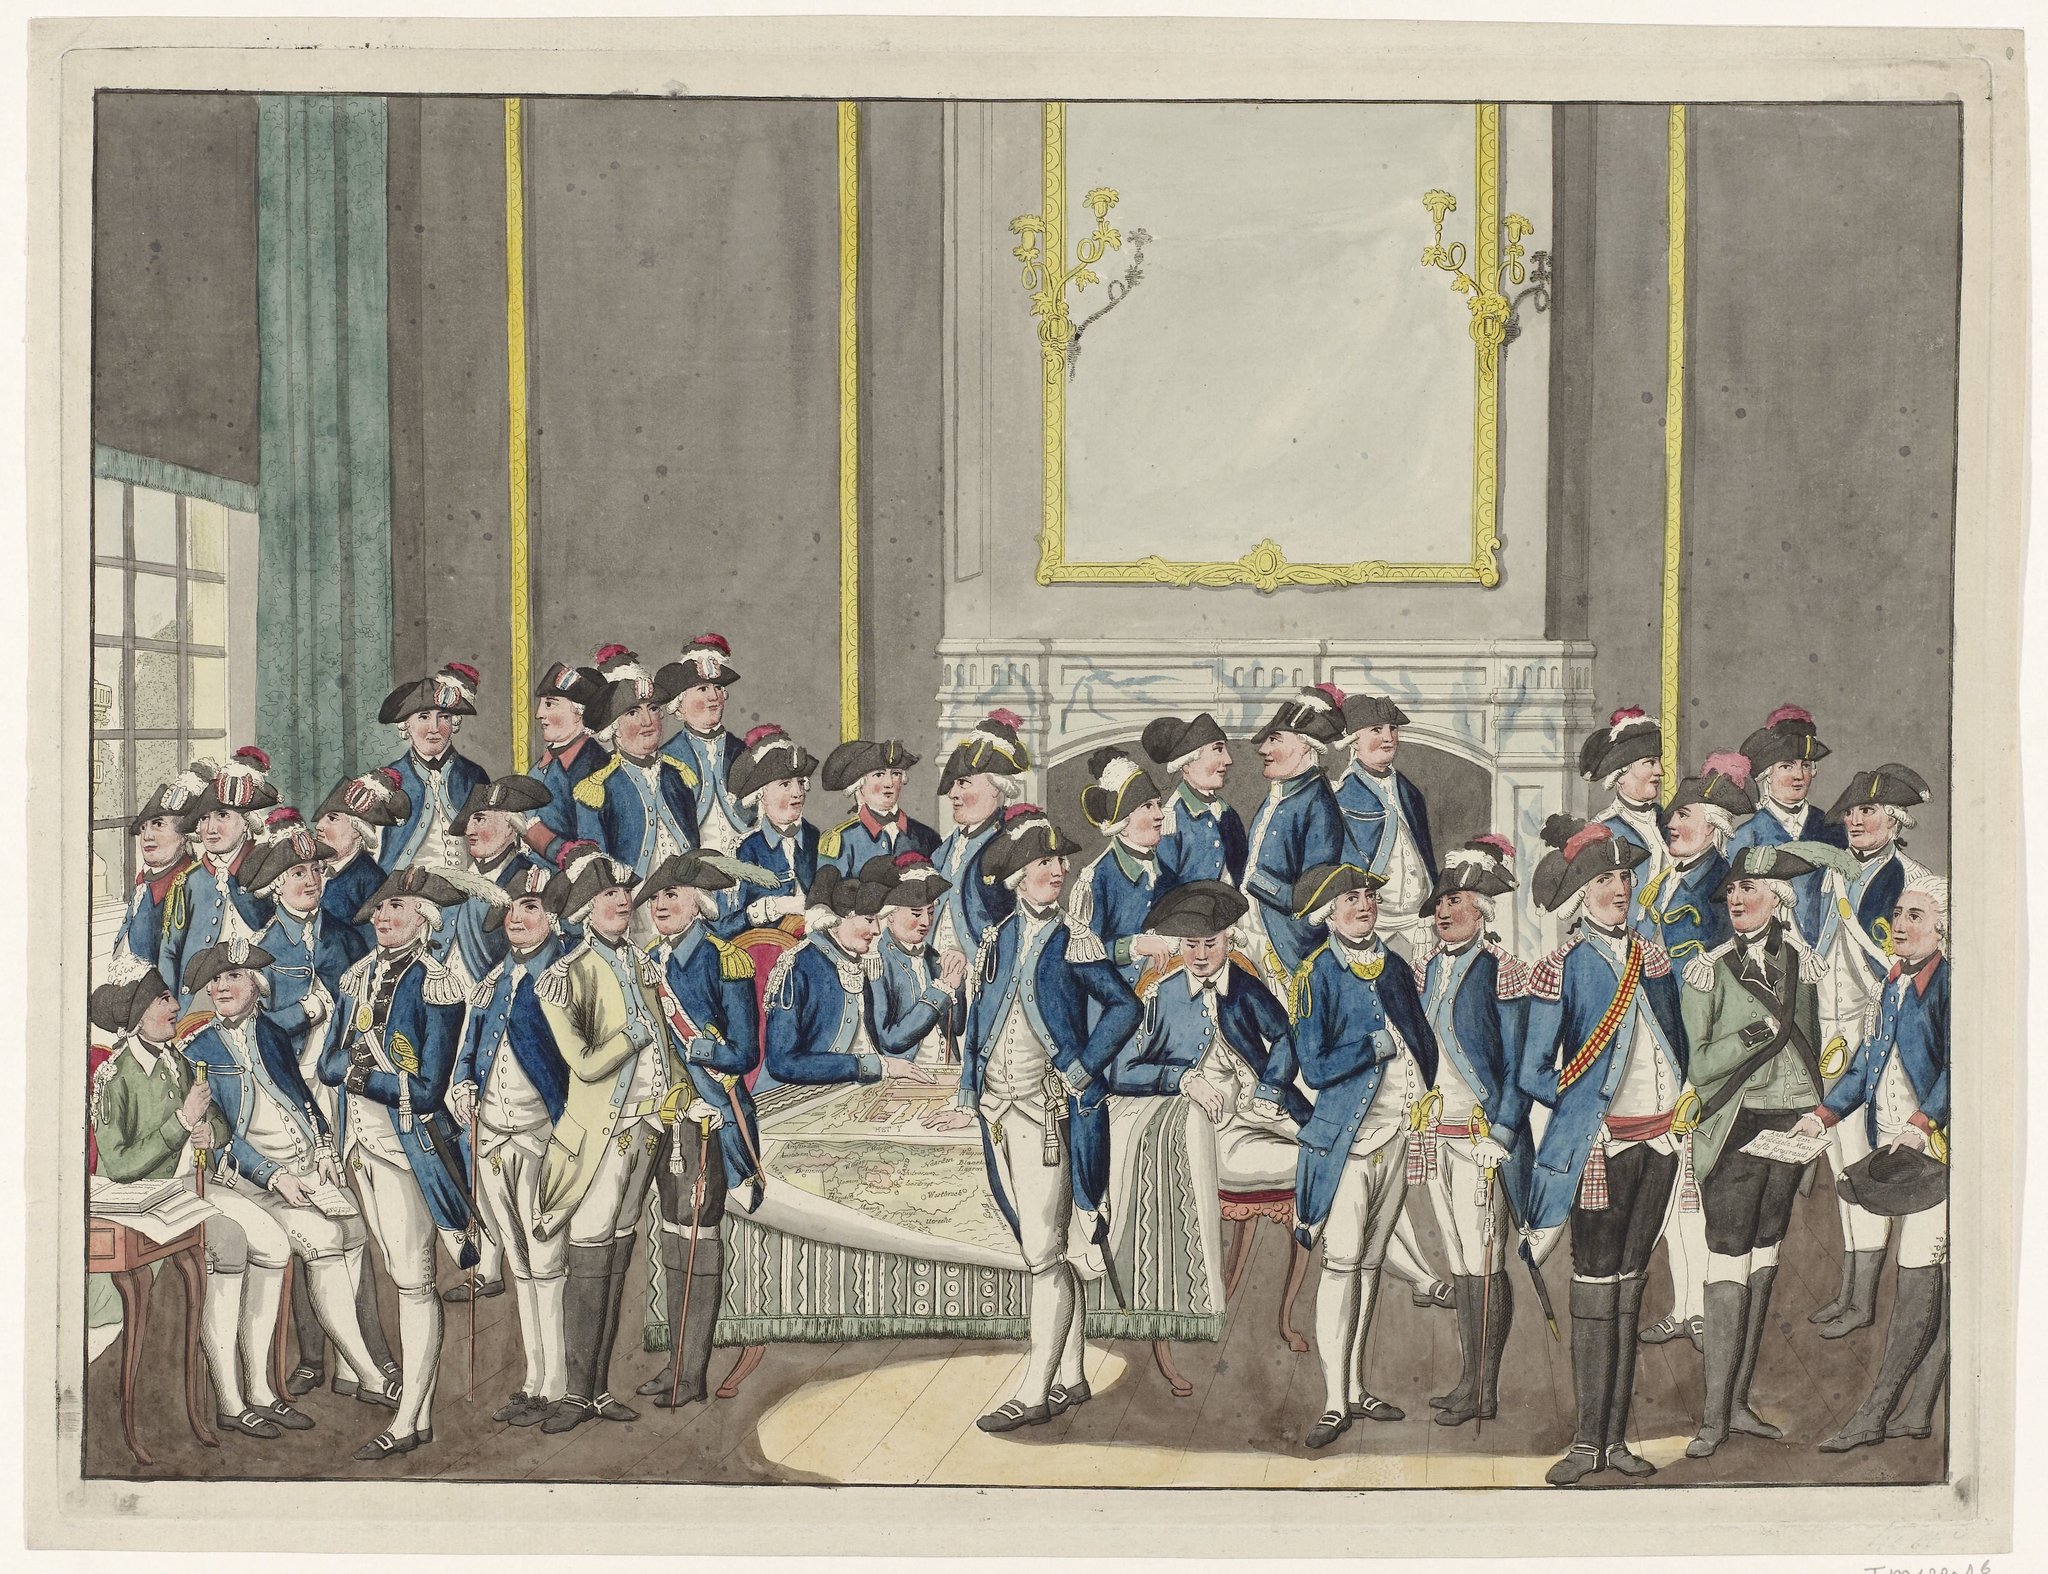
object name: costume print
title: Zaal met schutters in verschillende monteringen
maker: Anonymous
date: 1787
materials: paper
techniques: engraving, etching, hand coloring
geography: northern netherlands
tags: (military) uniforms (+ citizen soldiery, civil guard, citizen militia), patriots (1780-1795)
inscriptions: collector's mark: Lugt 2228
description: Zaal met 35 schutters in de verschillende monteringen (uniformen) van schutterijen en burgerkorpsen in Nederland in 1787. Op een tafel liggen kaarten die worden bestudeerd. Tegen de achterwand een spiegellijst.